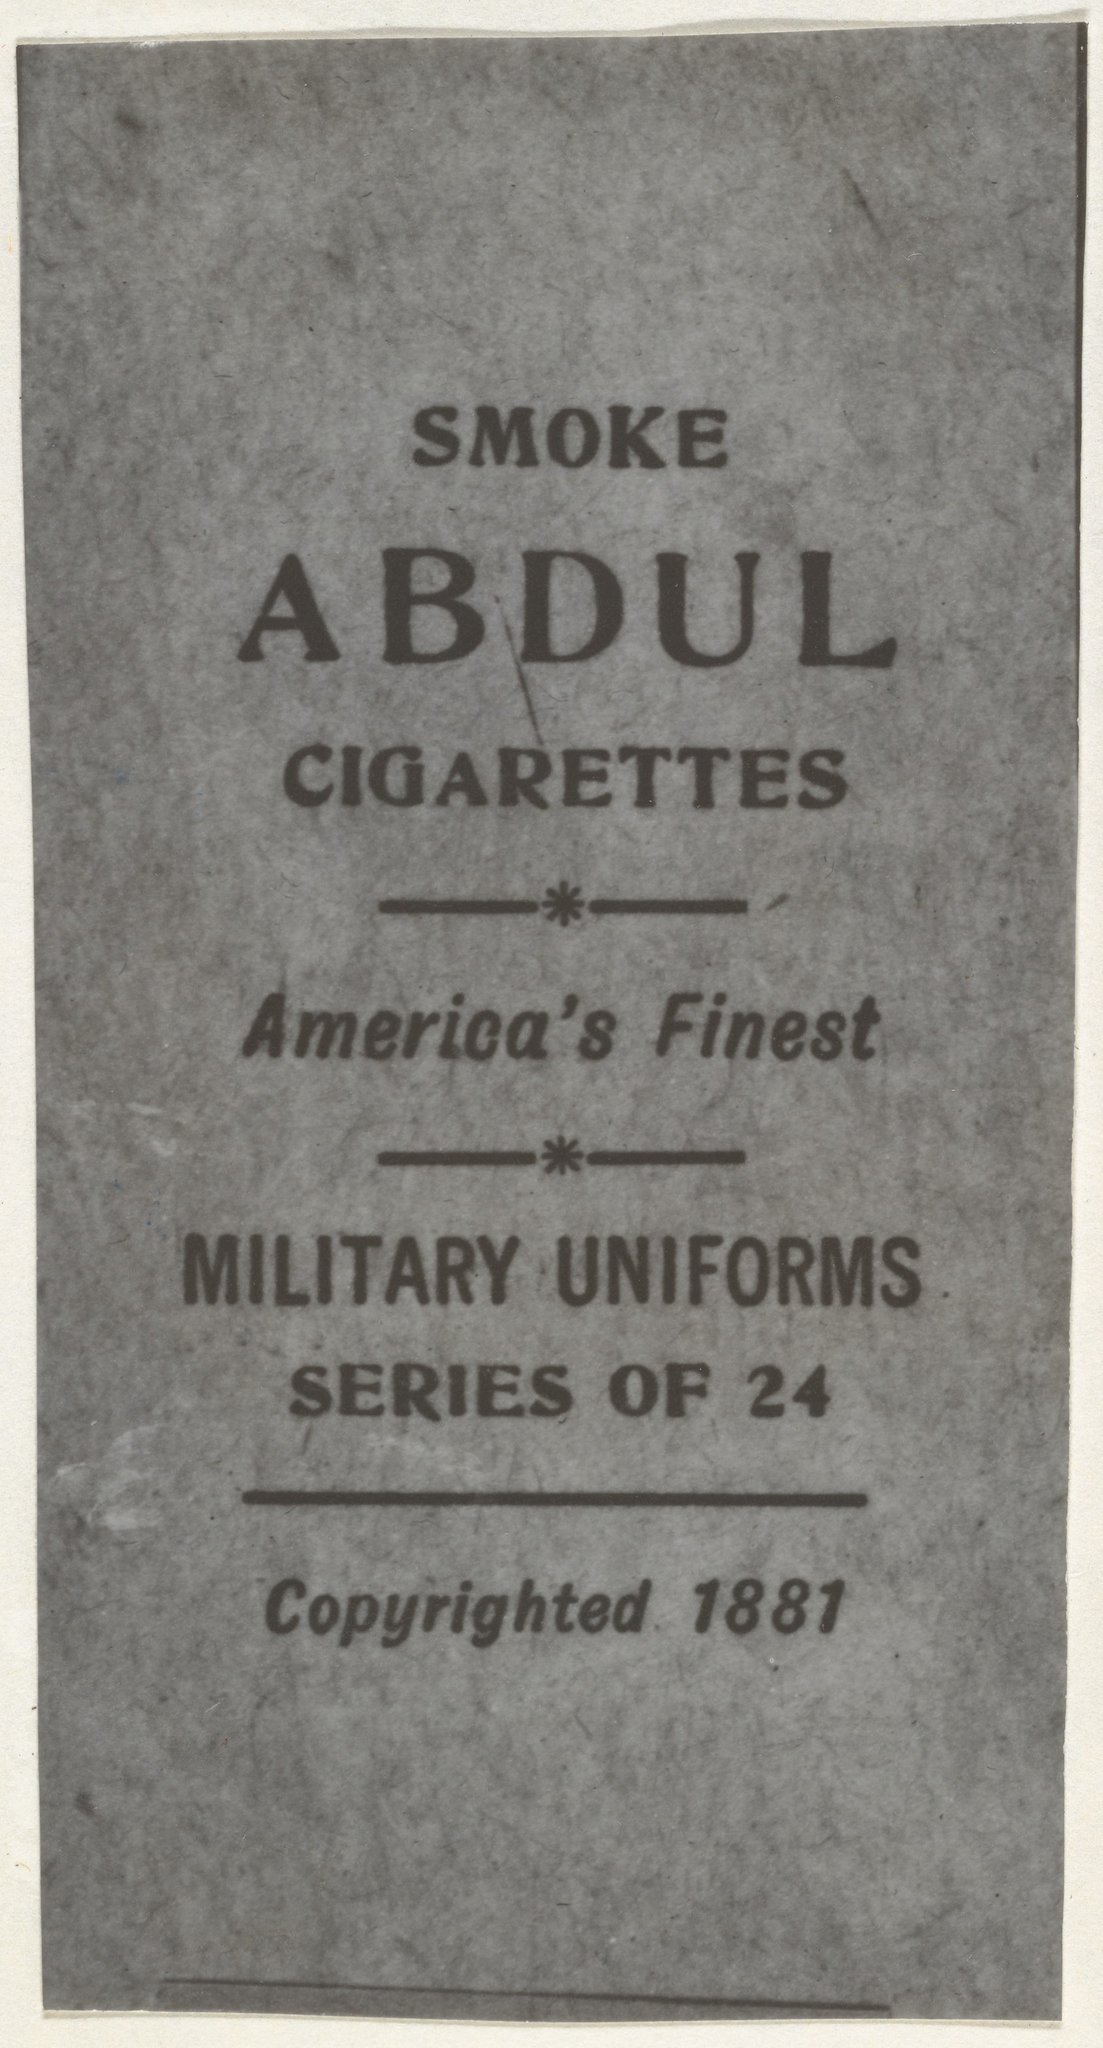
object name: print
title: Facsimile of card verso from the Military Uniforms series (T182) issued by Abdul Cigarettes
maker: abdul cigarettes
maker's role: publisher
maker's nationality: american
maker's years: 1881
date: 1881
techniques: color lithograph